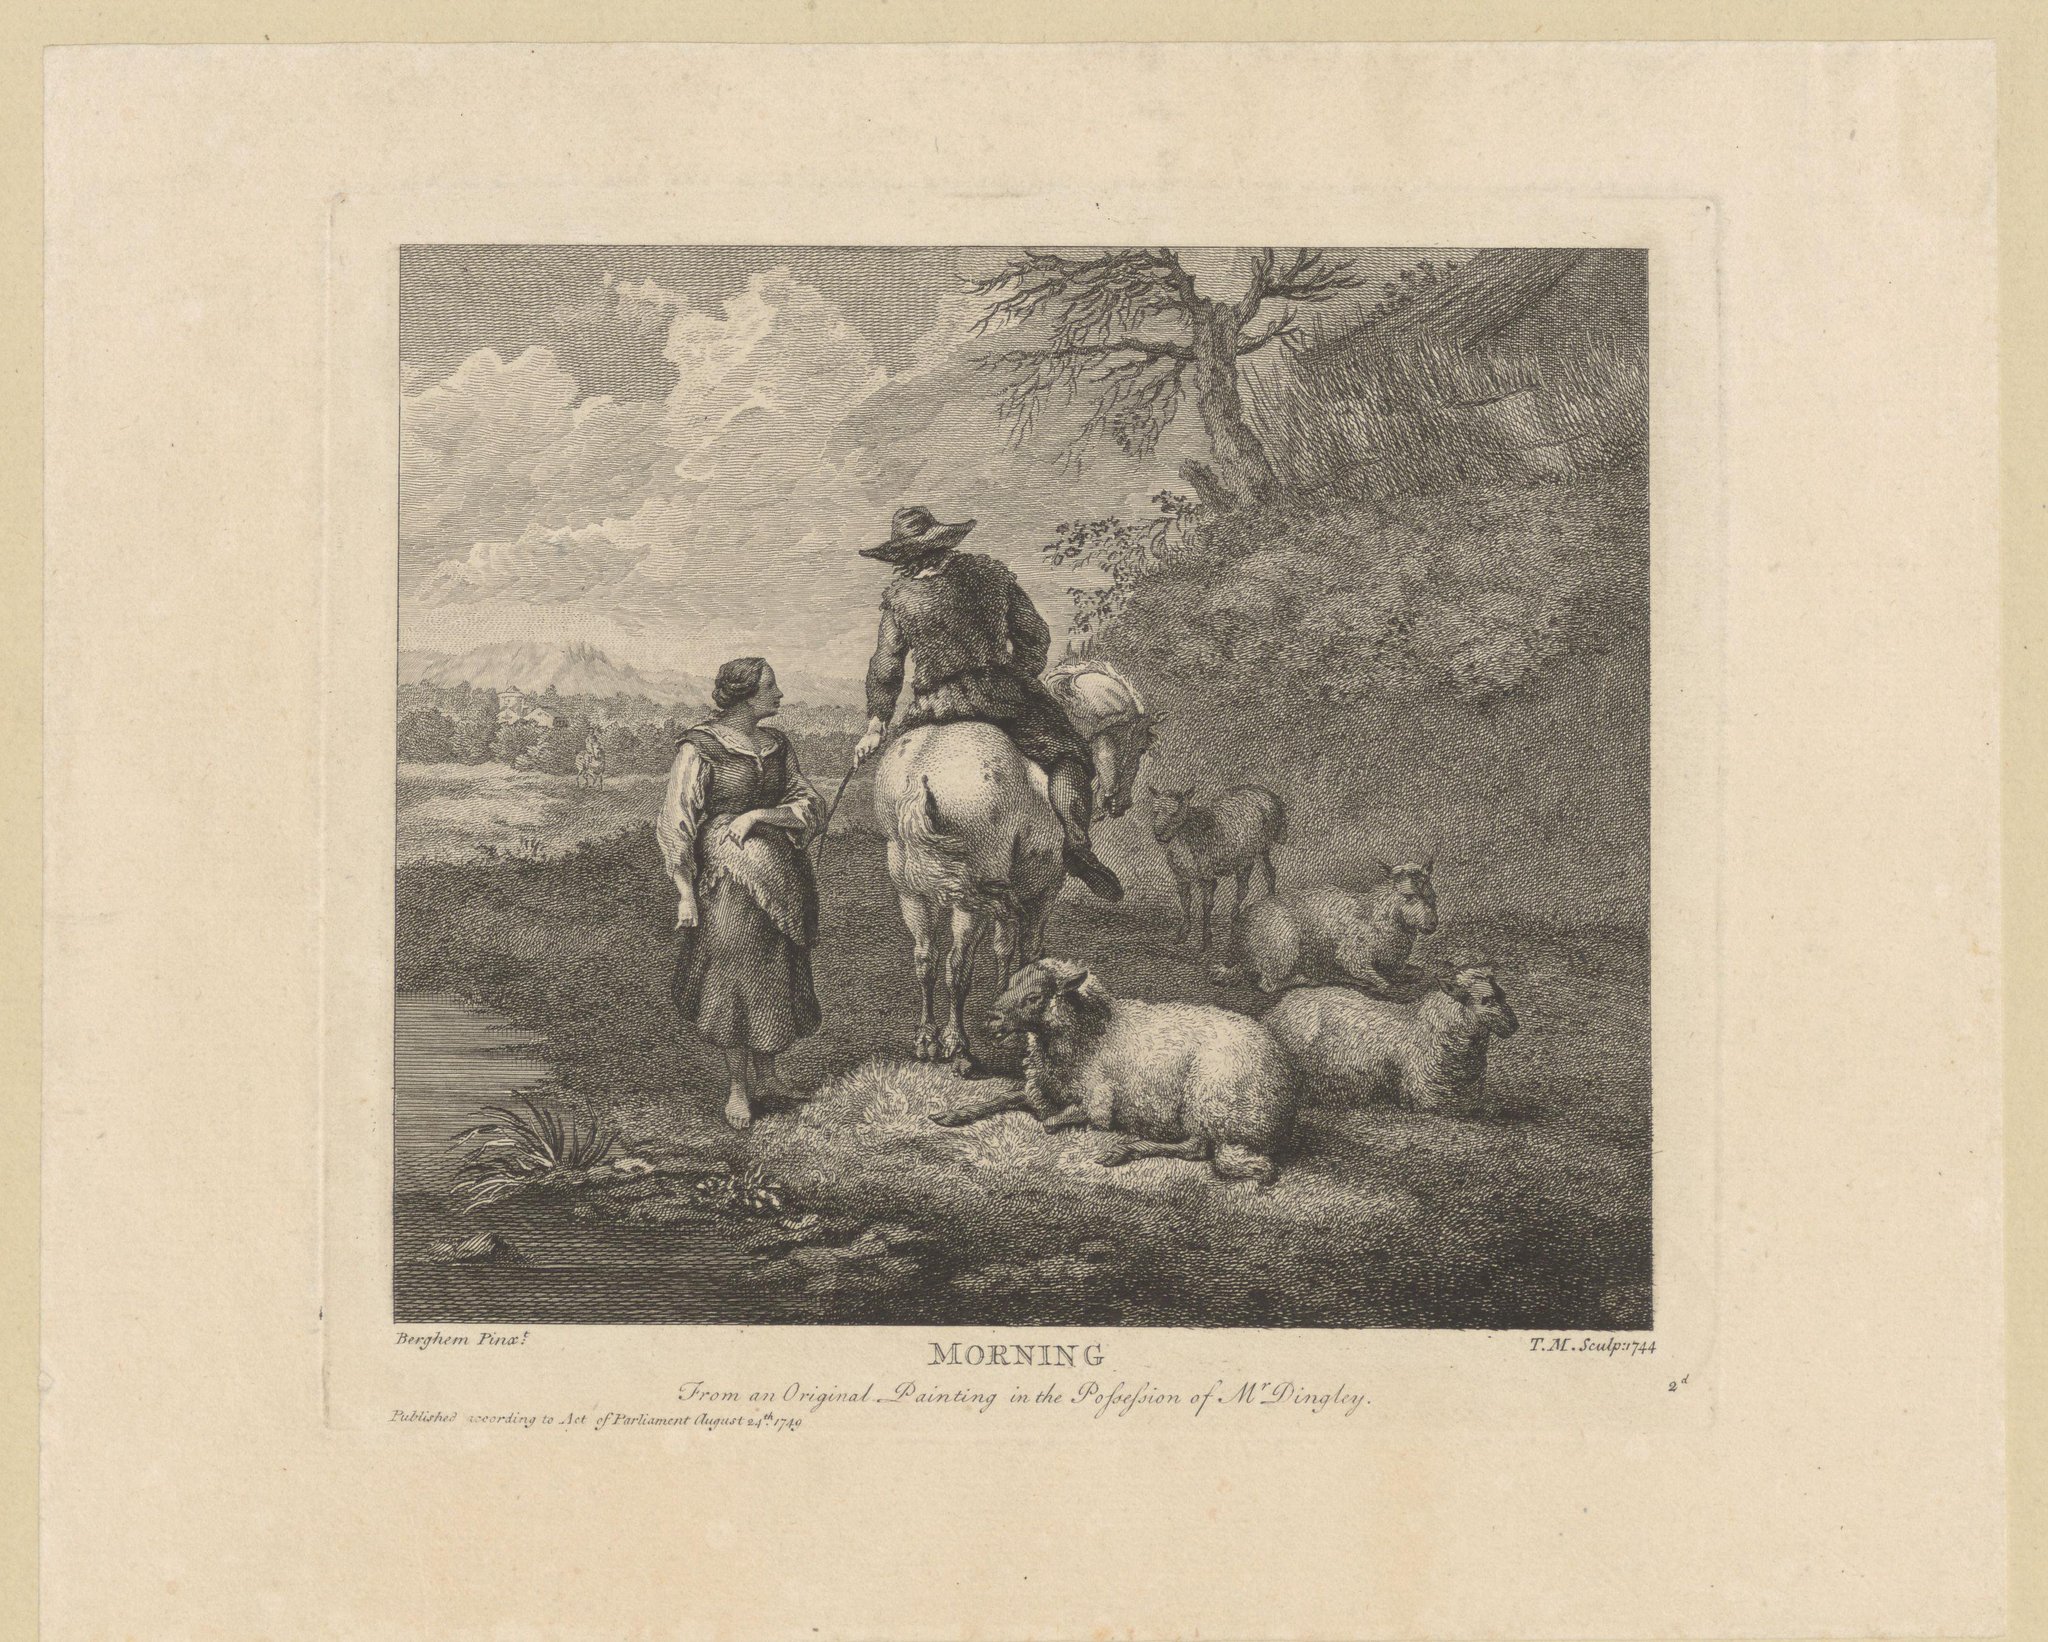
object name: print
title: Herder te paard en zijn vee bij een bron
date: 1744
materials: paper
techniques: etching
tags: morning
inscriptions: collector's mark: Lugt 240